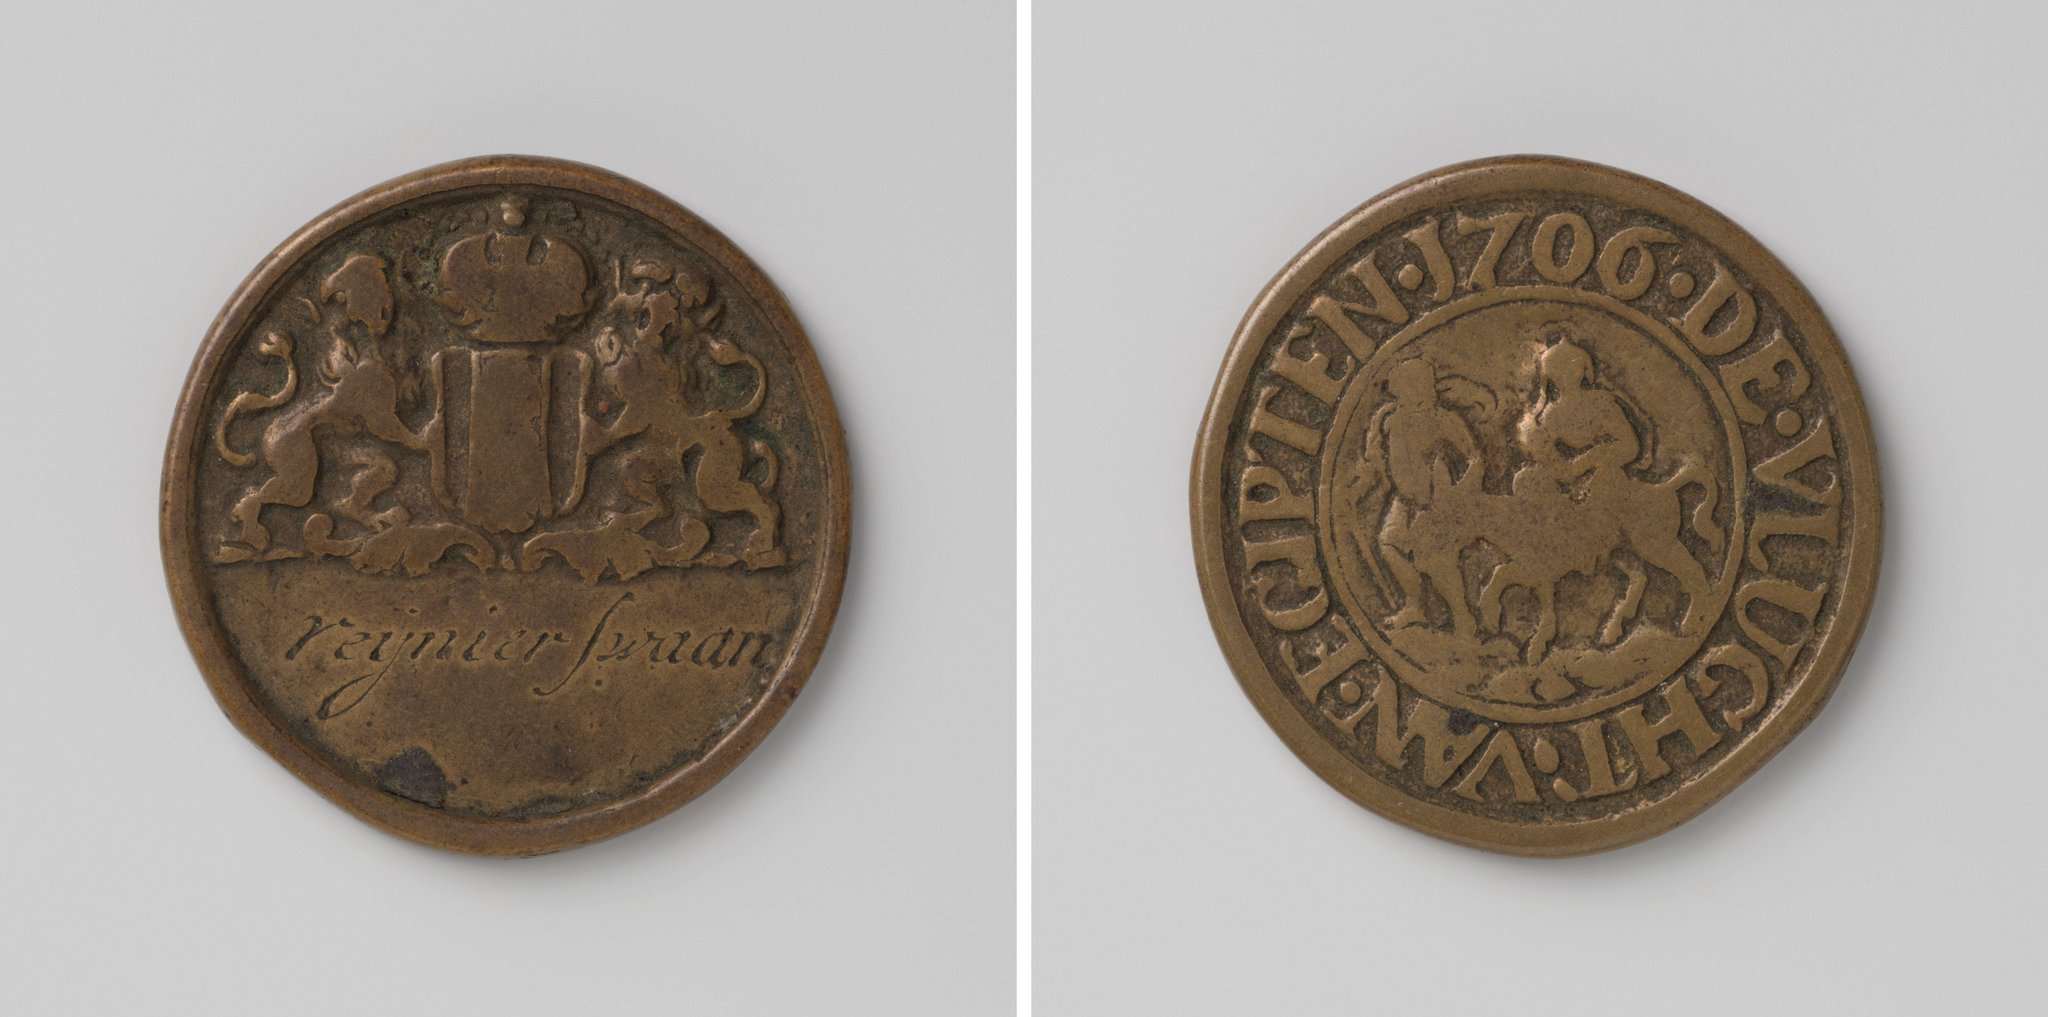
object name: medal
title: Timmerliedengilde van Amsterdam, gildepenning van Reynier Swaan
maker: Anonymous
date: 1706-1796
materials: brass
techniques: casting, engraving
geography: amsterdam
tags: amsterdam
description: Messing penning. Voorzijde: gekroond wapenschild, geflankeerd door twee leeuwen; afsnede: opschrift. Keerzijde: Maria, zittend met kind op ezeltje, dat door Jozef geleid wordt binnen omschrift